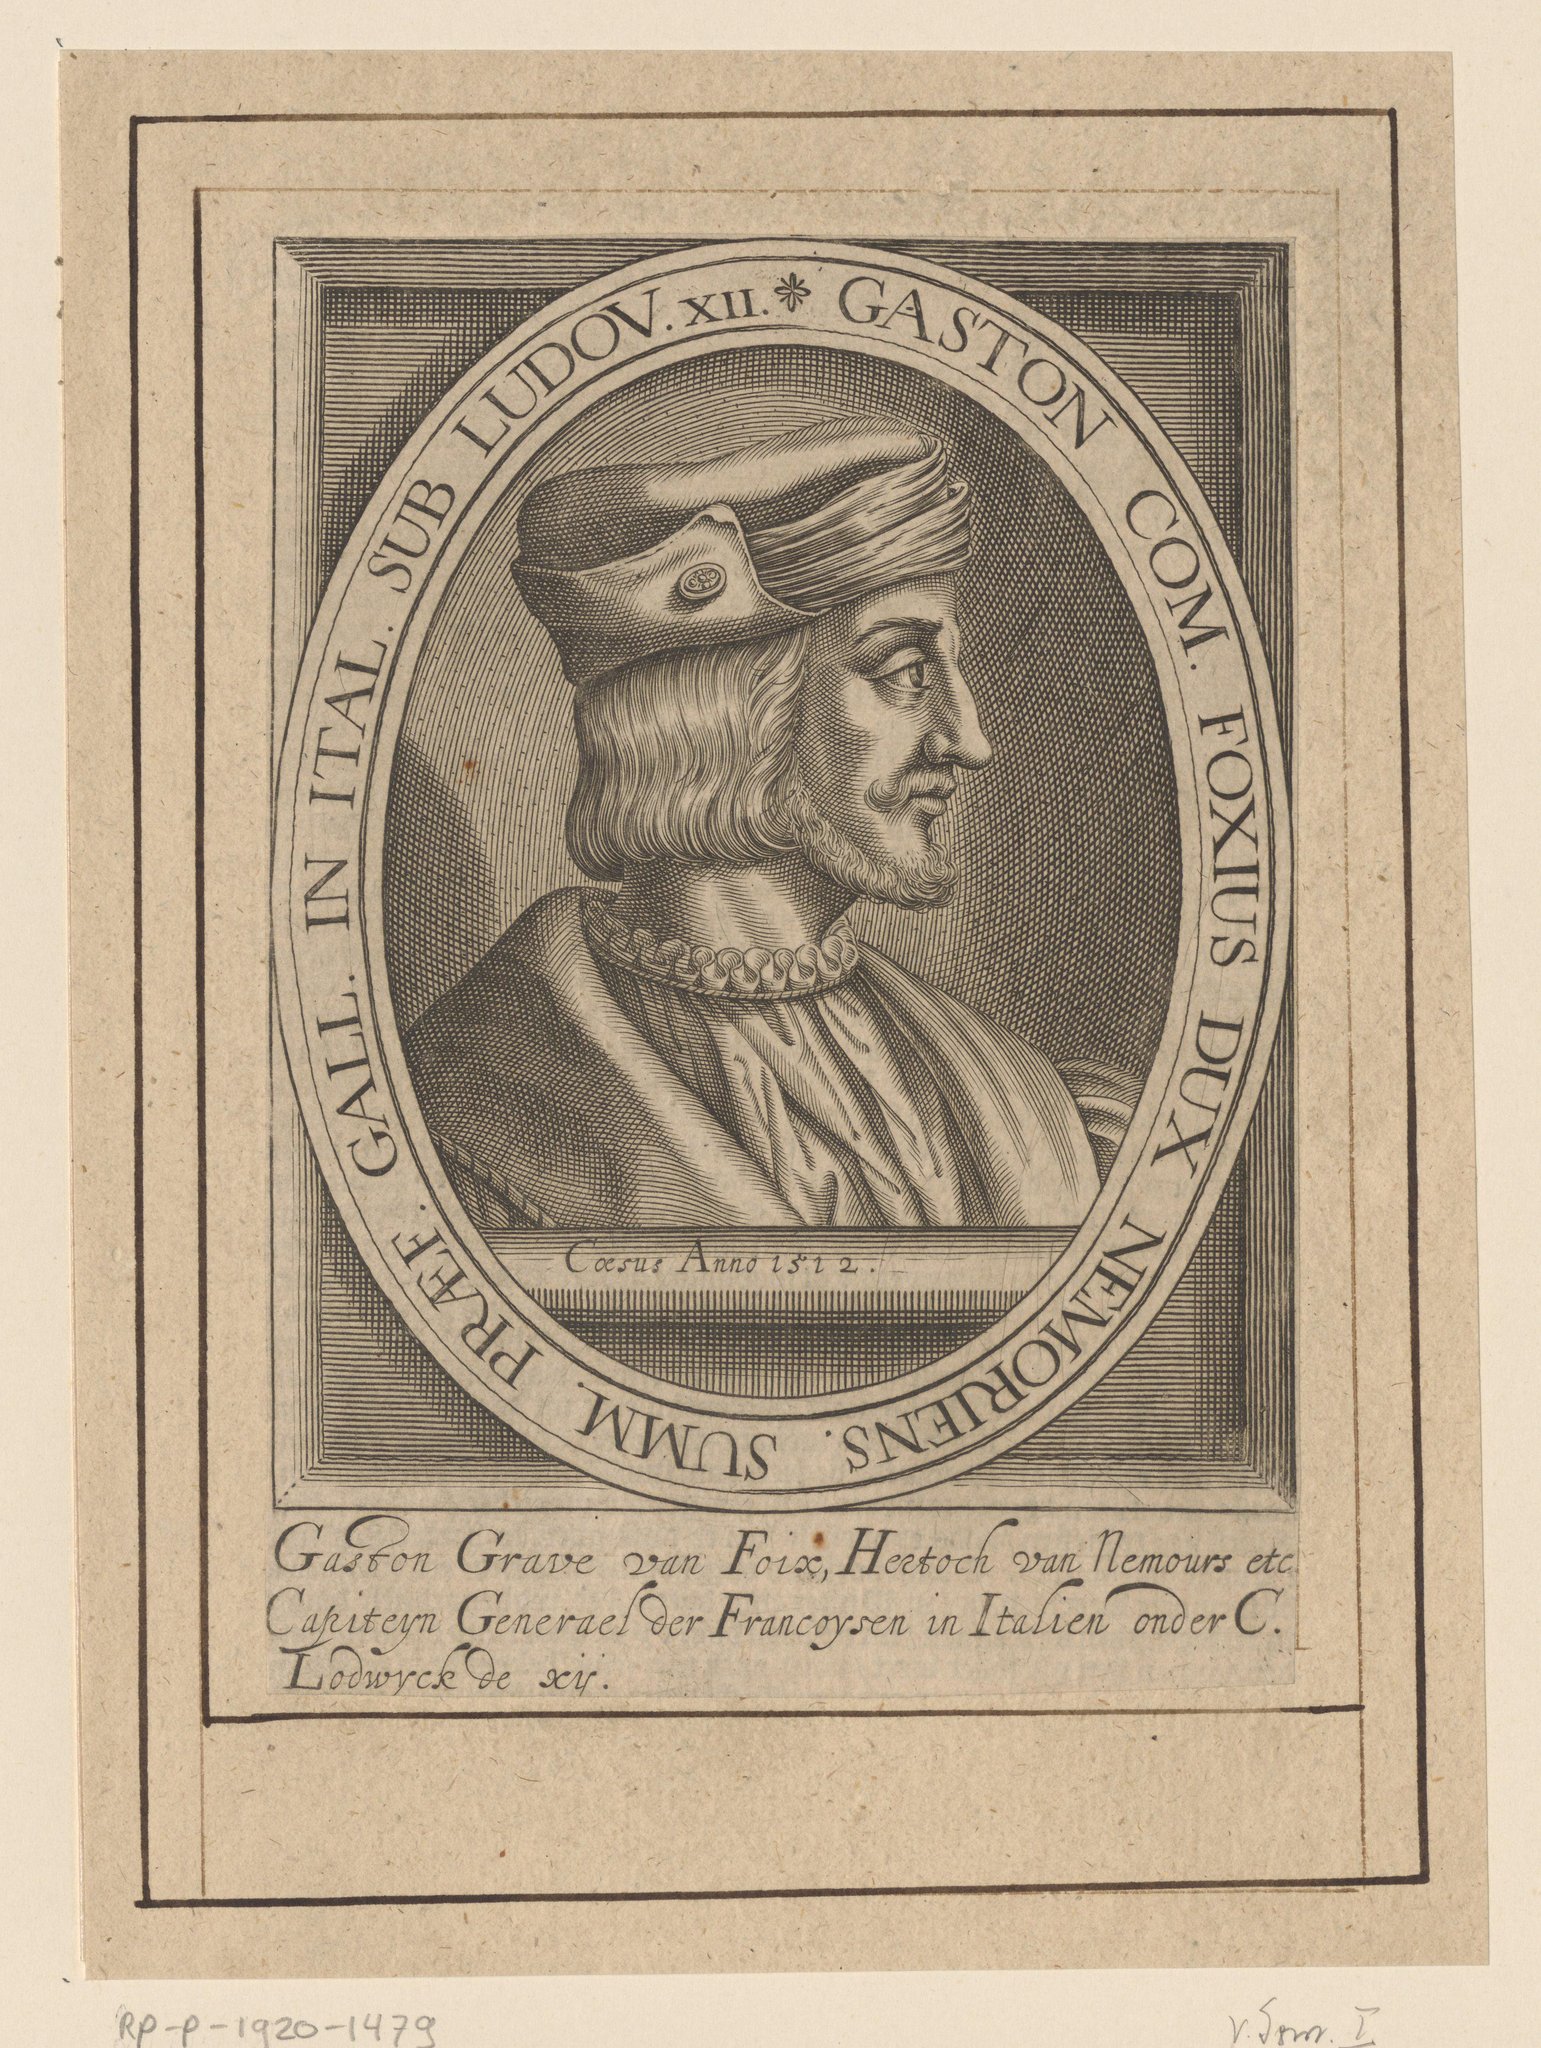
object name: print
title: Portret van Gaston de Foix, hertog van Nemours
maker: Anonymous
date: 1617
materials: paper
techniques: engraving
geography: northern netherlands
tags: historical persons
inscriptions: collector's mark: Lugt 2228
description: Prent waarschijnlijk uit: Tooneel der beroemder hertogen princen graven ende krygs-helden van christenrijck binnen deze drij laetste eeuwen. Delft: Nicolaes de Clerck, 1617. Mogelijk ook gebruikt in andere publicaties, bijvoorbeeld Van Meterens 'Nederlantsche Historien'.